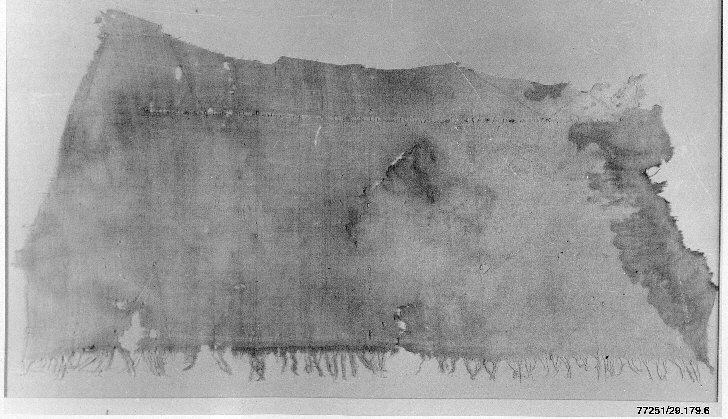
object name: textile fragment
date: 901-1000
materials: linen, silk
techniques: weave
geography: egypt